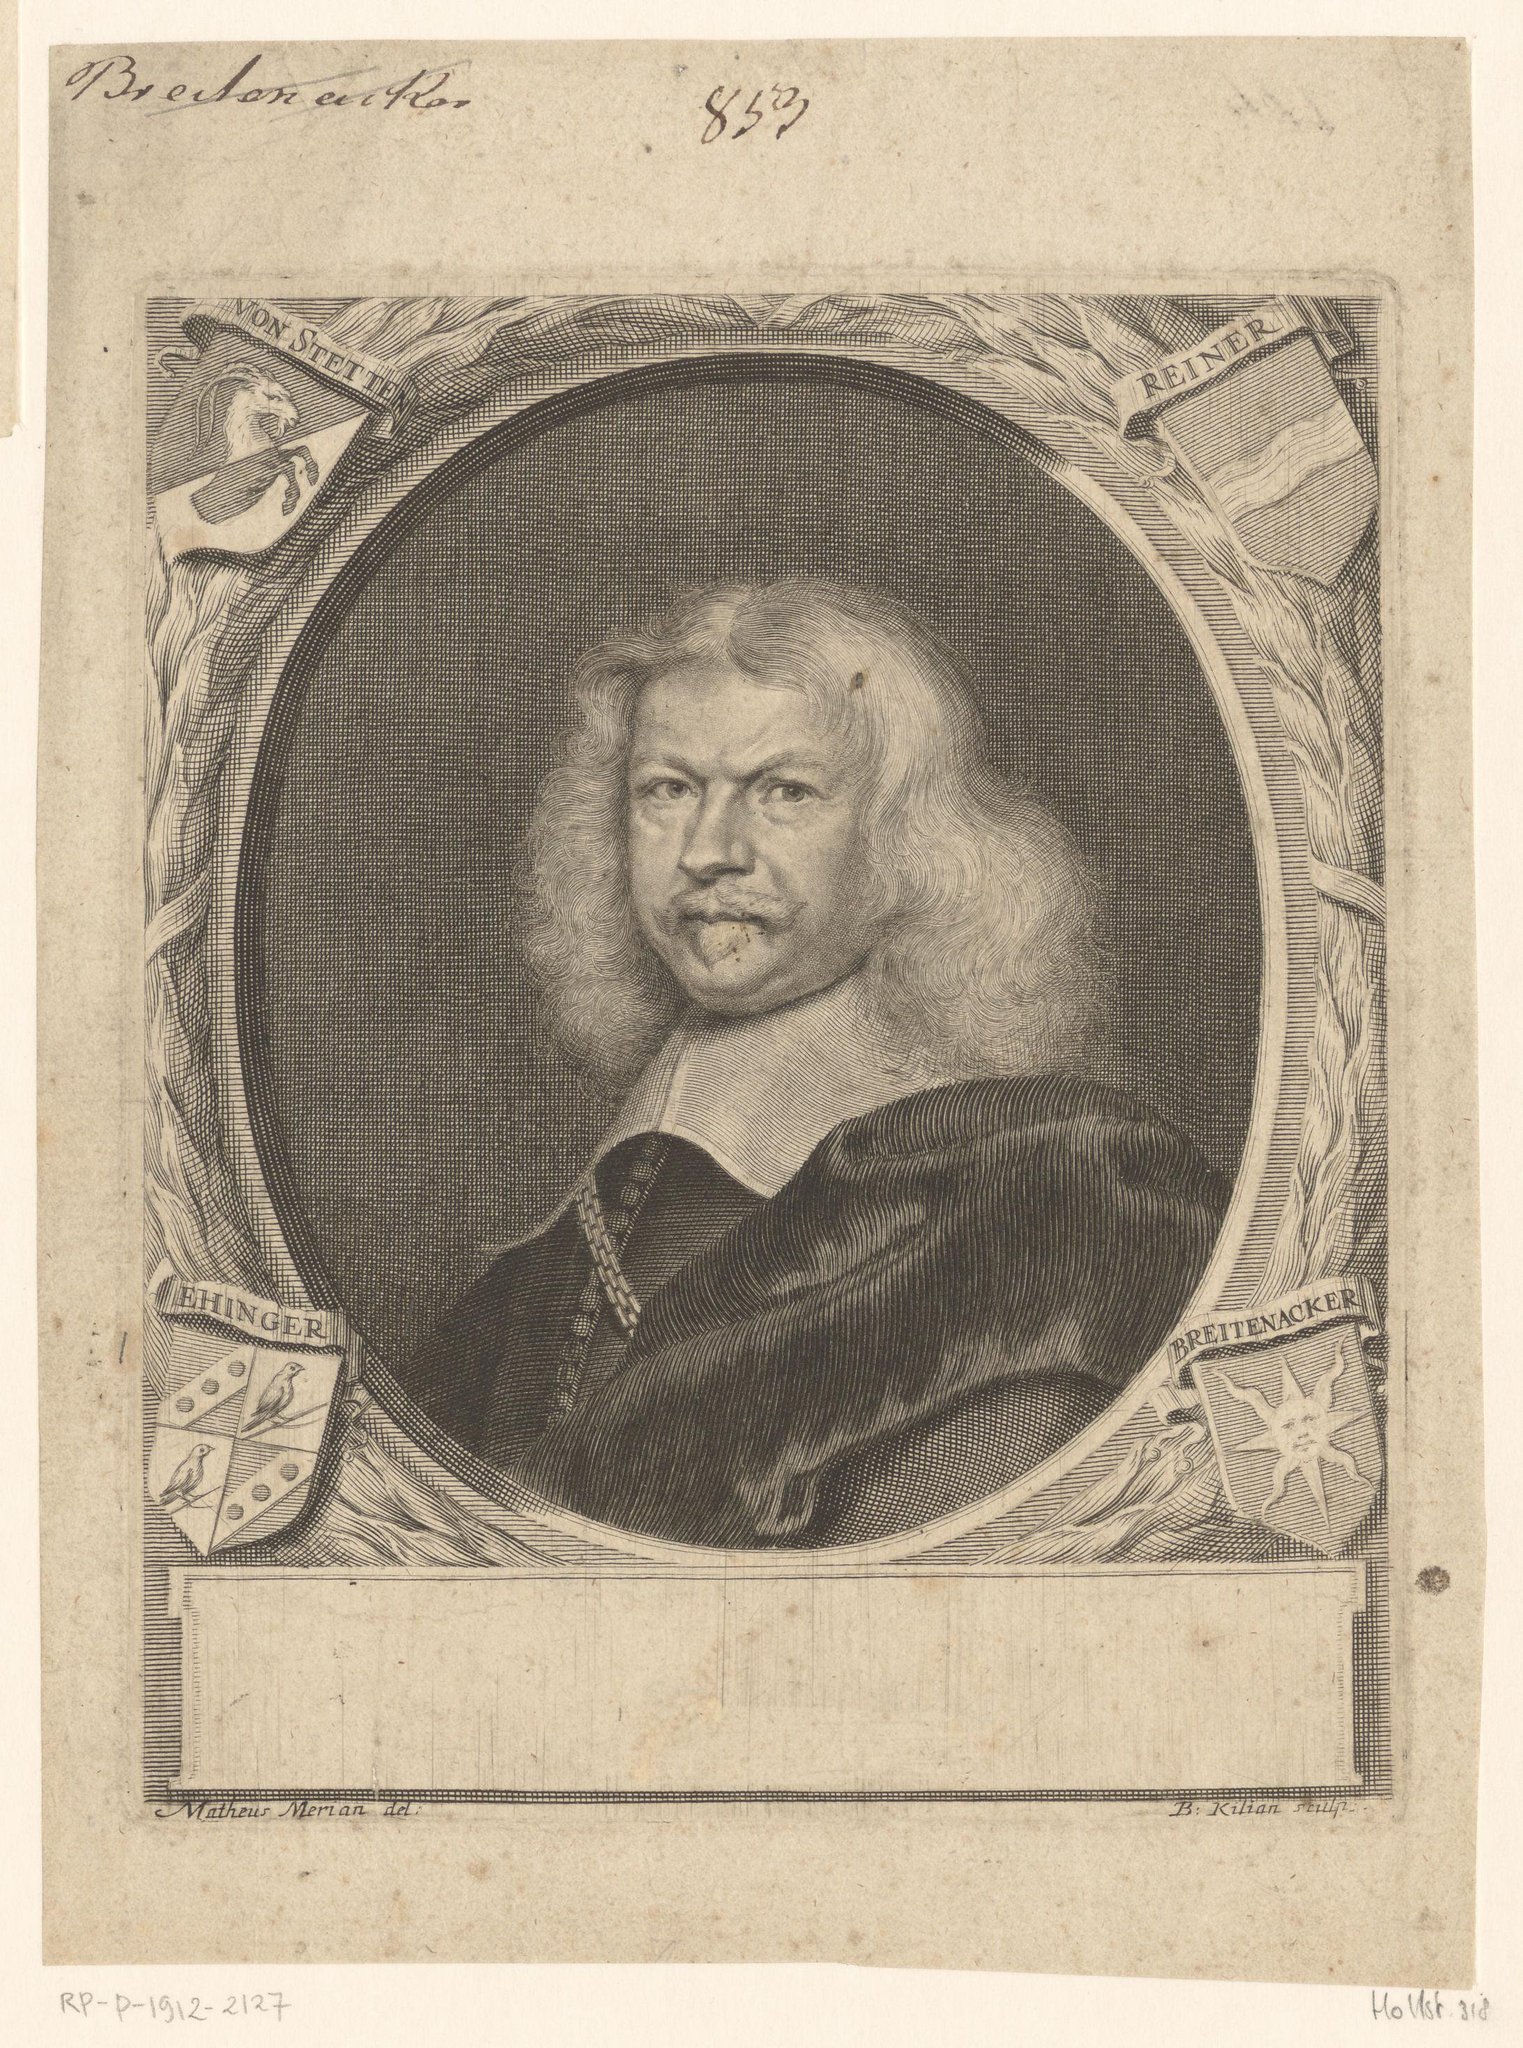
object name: print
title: Portret van Hieronymus Petrus von Stetten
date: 1686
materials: paper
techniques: engraving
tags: historical persons, lawyer, attorney at law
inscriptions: collector's mark: Lugt 2228